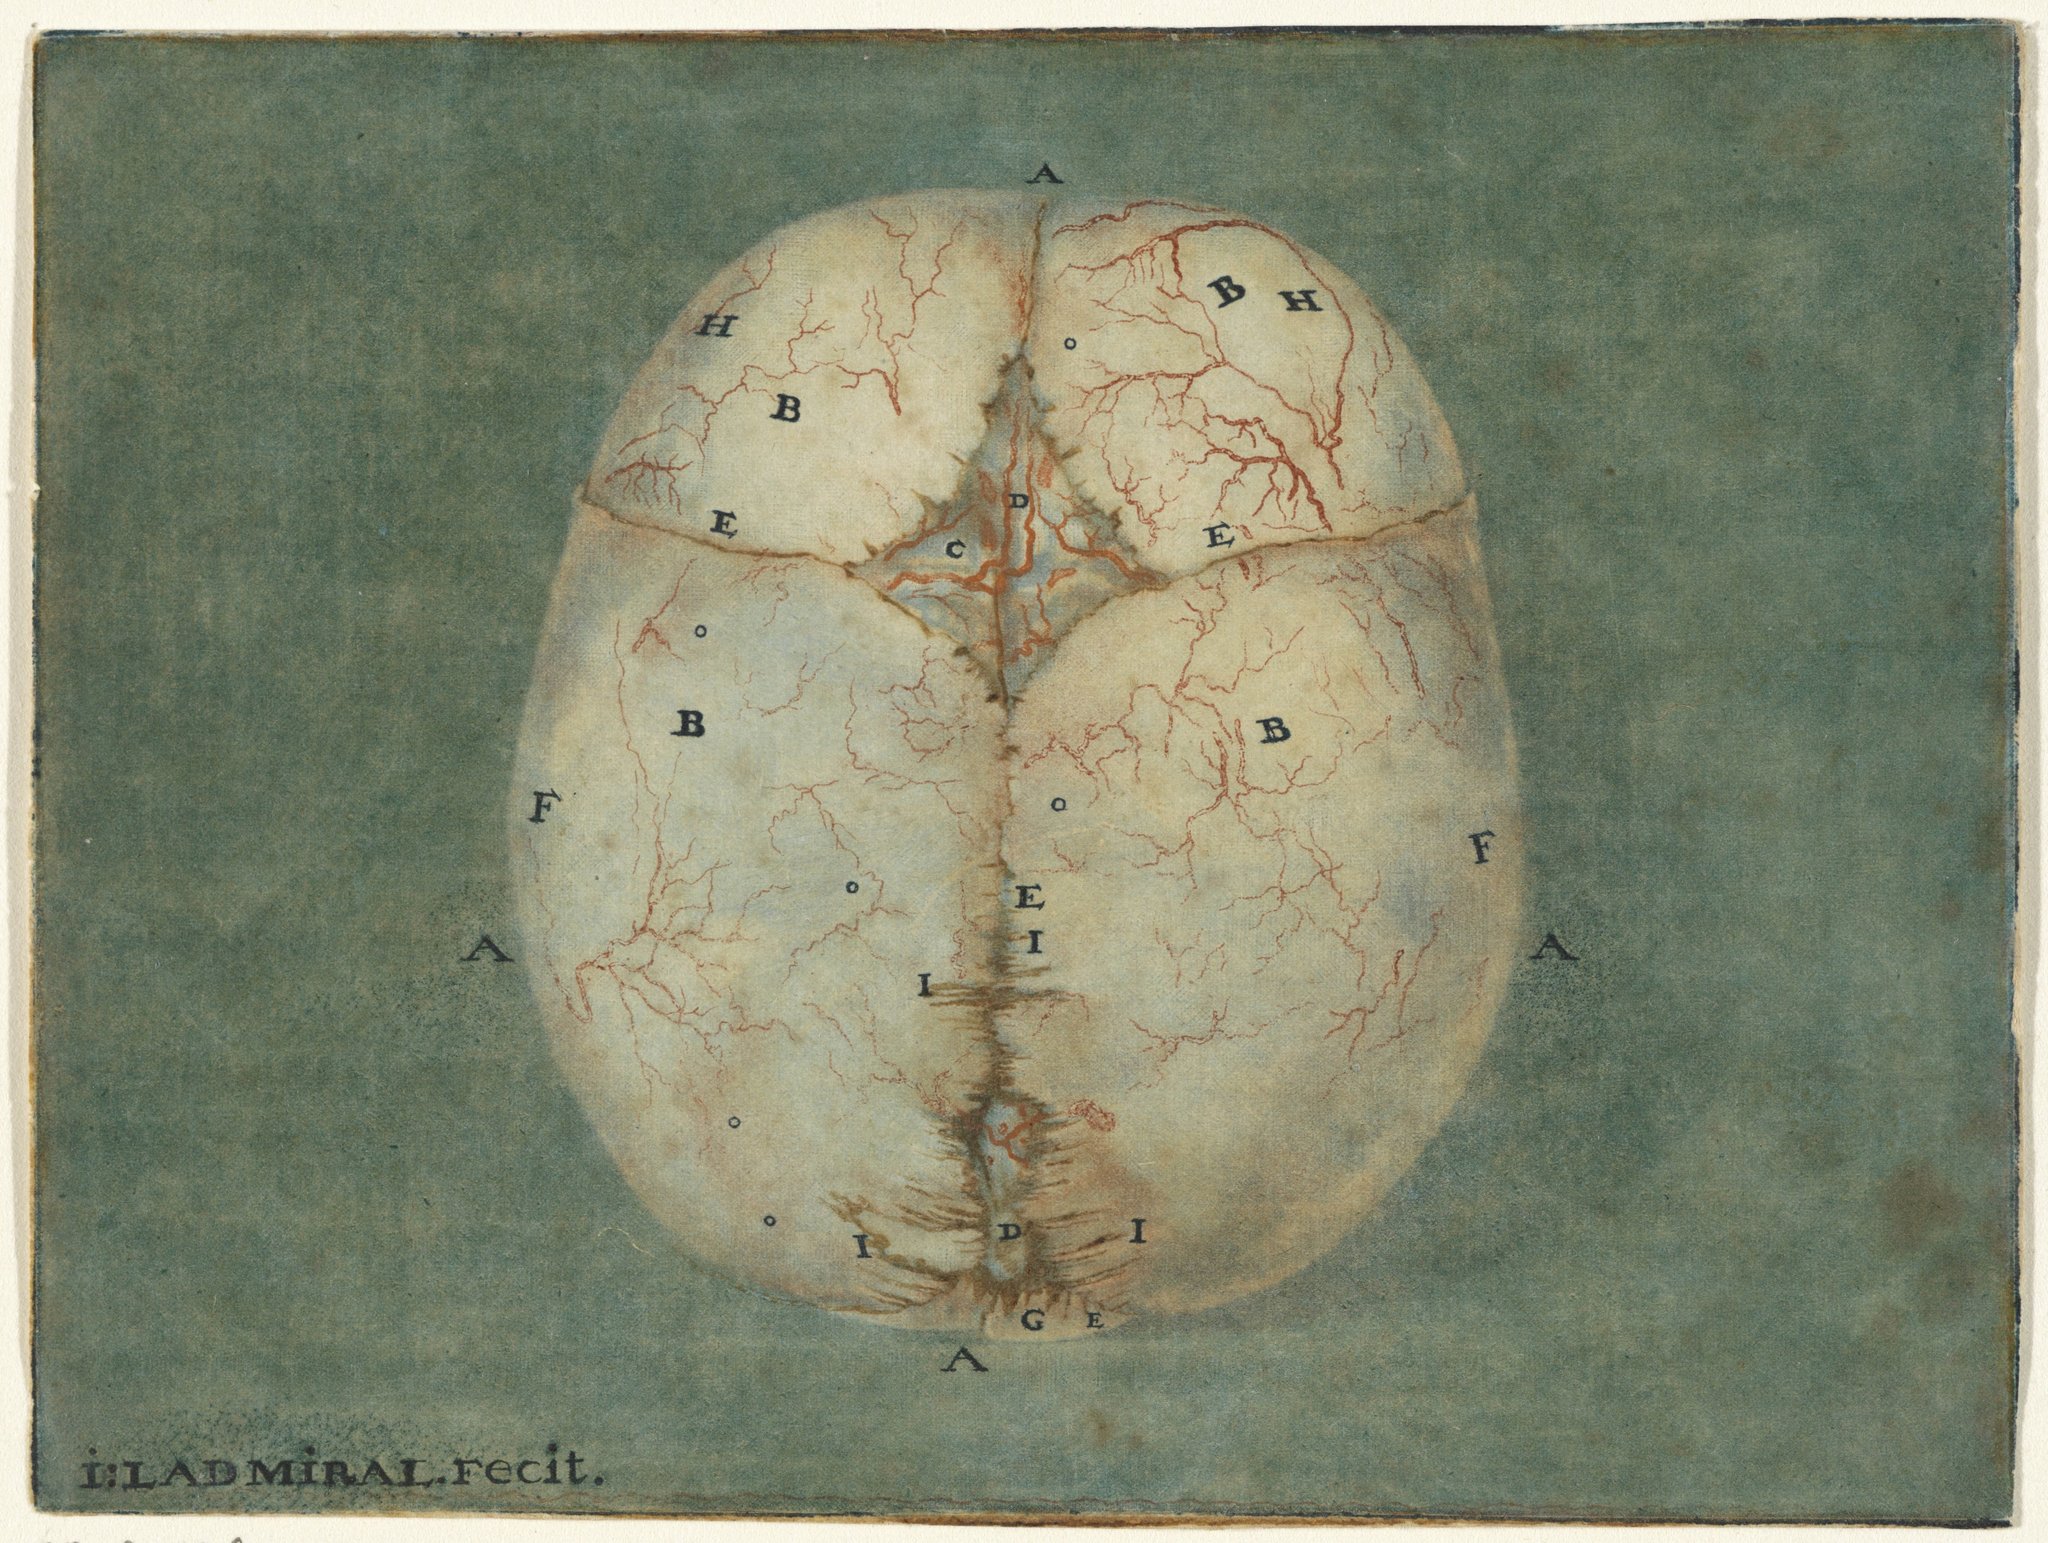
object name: print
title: Prints of the Brain and the Heart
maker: jan l admiral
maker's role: draughtsman, print maker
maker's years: 1699-1773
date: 1733-1738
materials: paper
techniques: color etching, mezzotint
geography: amsterdam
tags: (human) skull, other anatomical details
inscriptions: collector's mark: Lugt 2228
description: Around 1735 Jan l’Admiral printed several remarkable anatomical prints in colour, among others on commission for the celebrated physician Frederik Ruysch. For his illustrations of the cerebral membrane (the skull of an unborn child) and a human heart he experimented with ever different colours, and made various versions of them. The objective was to provide medical practitioners with the most precise and realistic images possible.